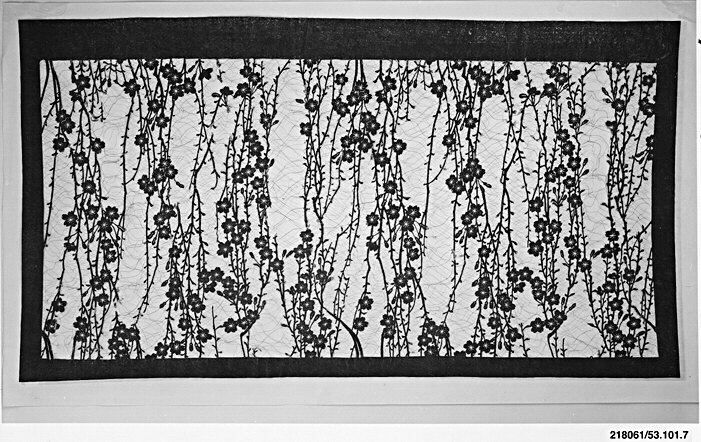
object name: stencil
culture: japanese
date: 1615-1868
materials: paper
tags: flowers